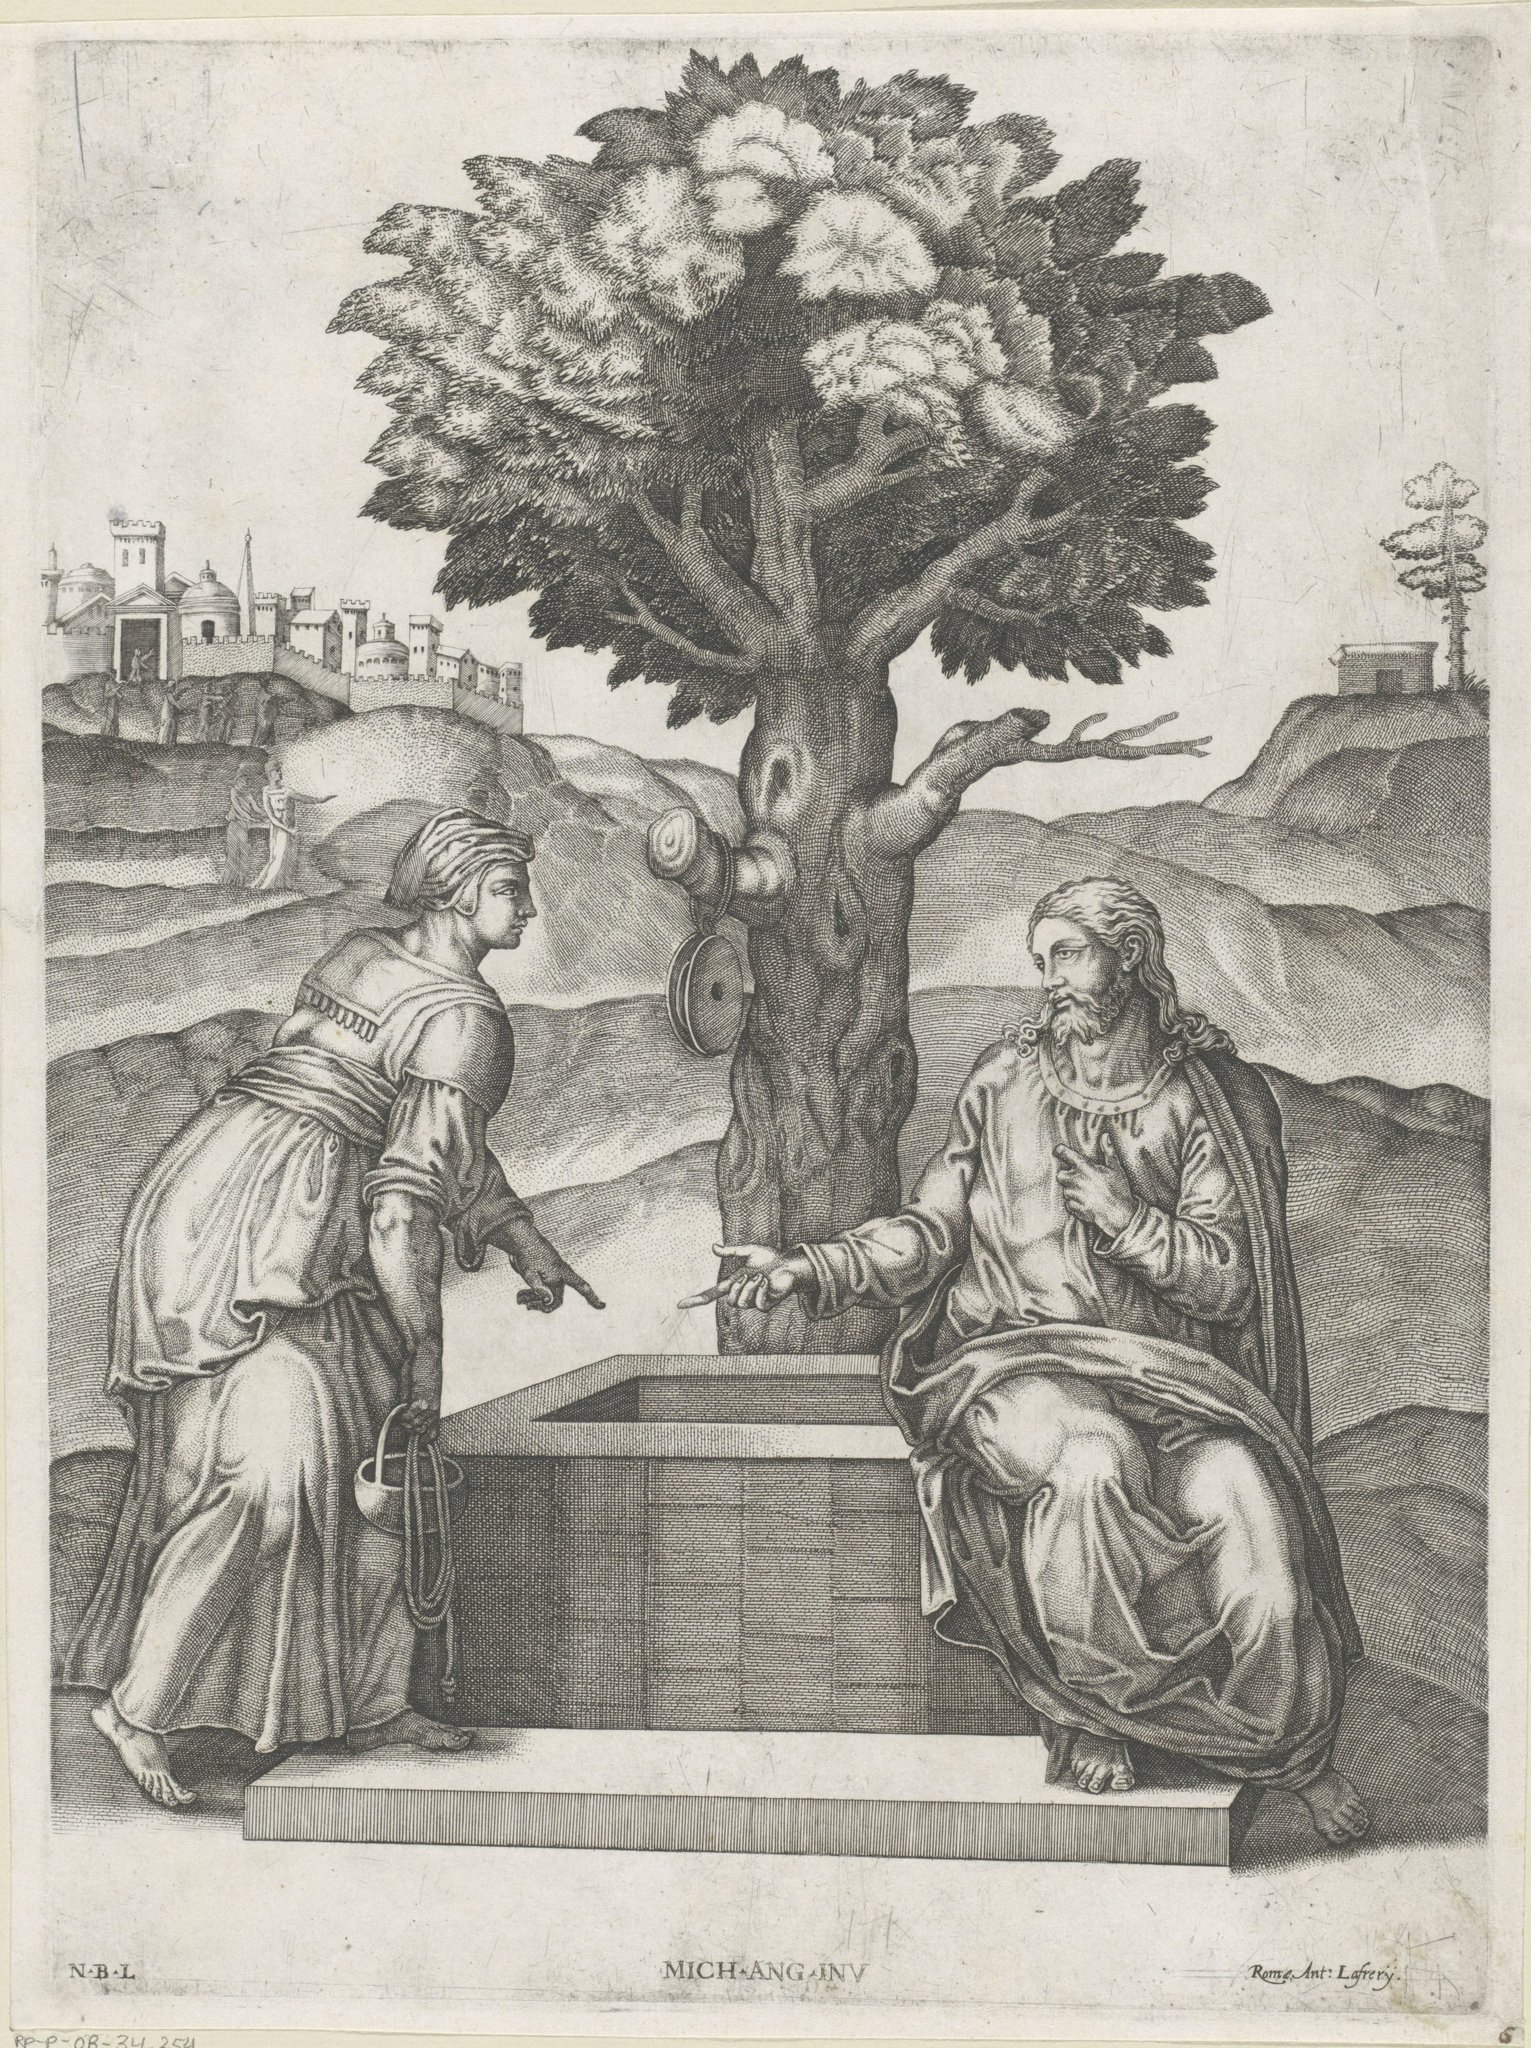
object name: print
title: Christus en de Samaritaanse vrouw bij de put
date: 1525-1565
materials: paper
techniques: engraving, etching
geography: rome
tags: christ and the woman of samaria: sitting at jacob's well he asks her for a drink from her jug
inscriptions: collector's mark: Lugt 240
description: Christus zit op de rand van een put. Links van de put staat de Samaritaanse vrouw. Achter de put staat een boom. Op de achtergrond links een stad.